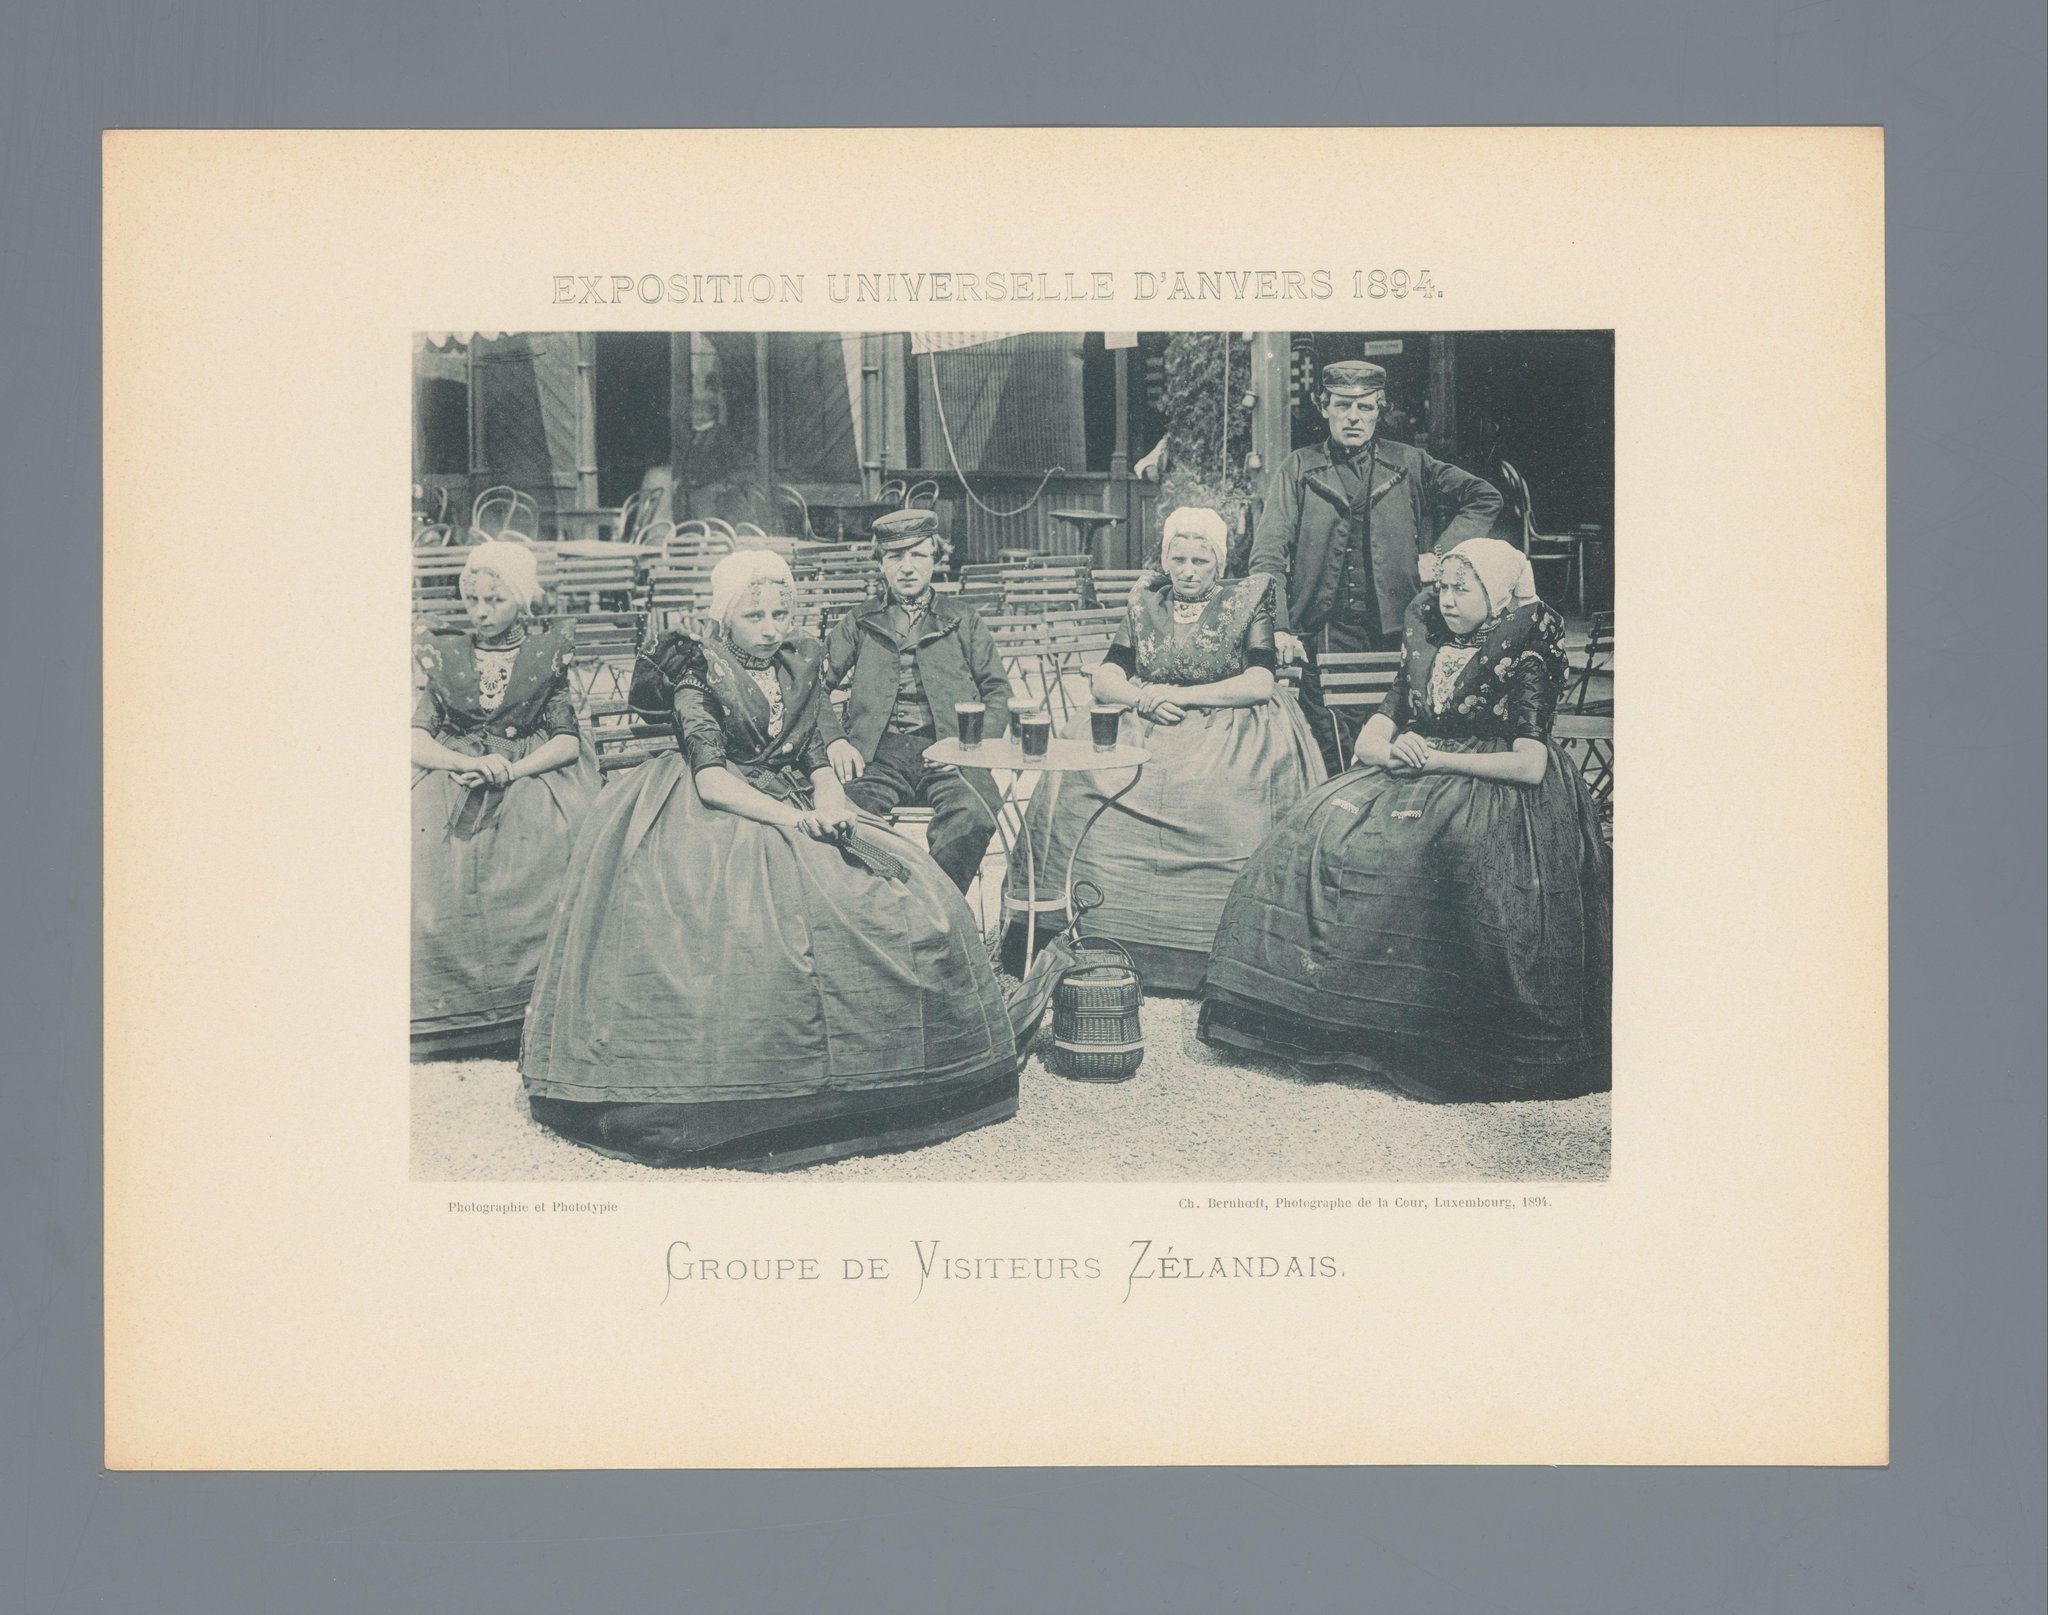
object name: photomechanical print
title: Onbekende mannen en vrouwen in Zeeuwse klederdracht tijdens de Wereldtentoonstelling van 1894 te Antwerpen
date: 1894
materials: paper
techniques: photograph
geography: antwerp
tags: europeans, world fair, world exhibition, historical persons, antwerp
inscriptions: inscription: ‘Exposition Universelle D'Anvers 1894.’